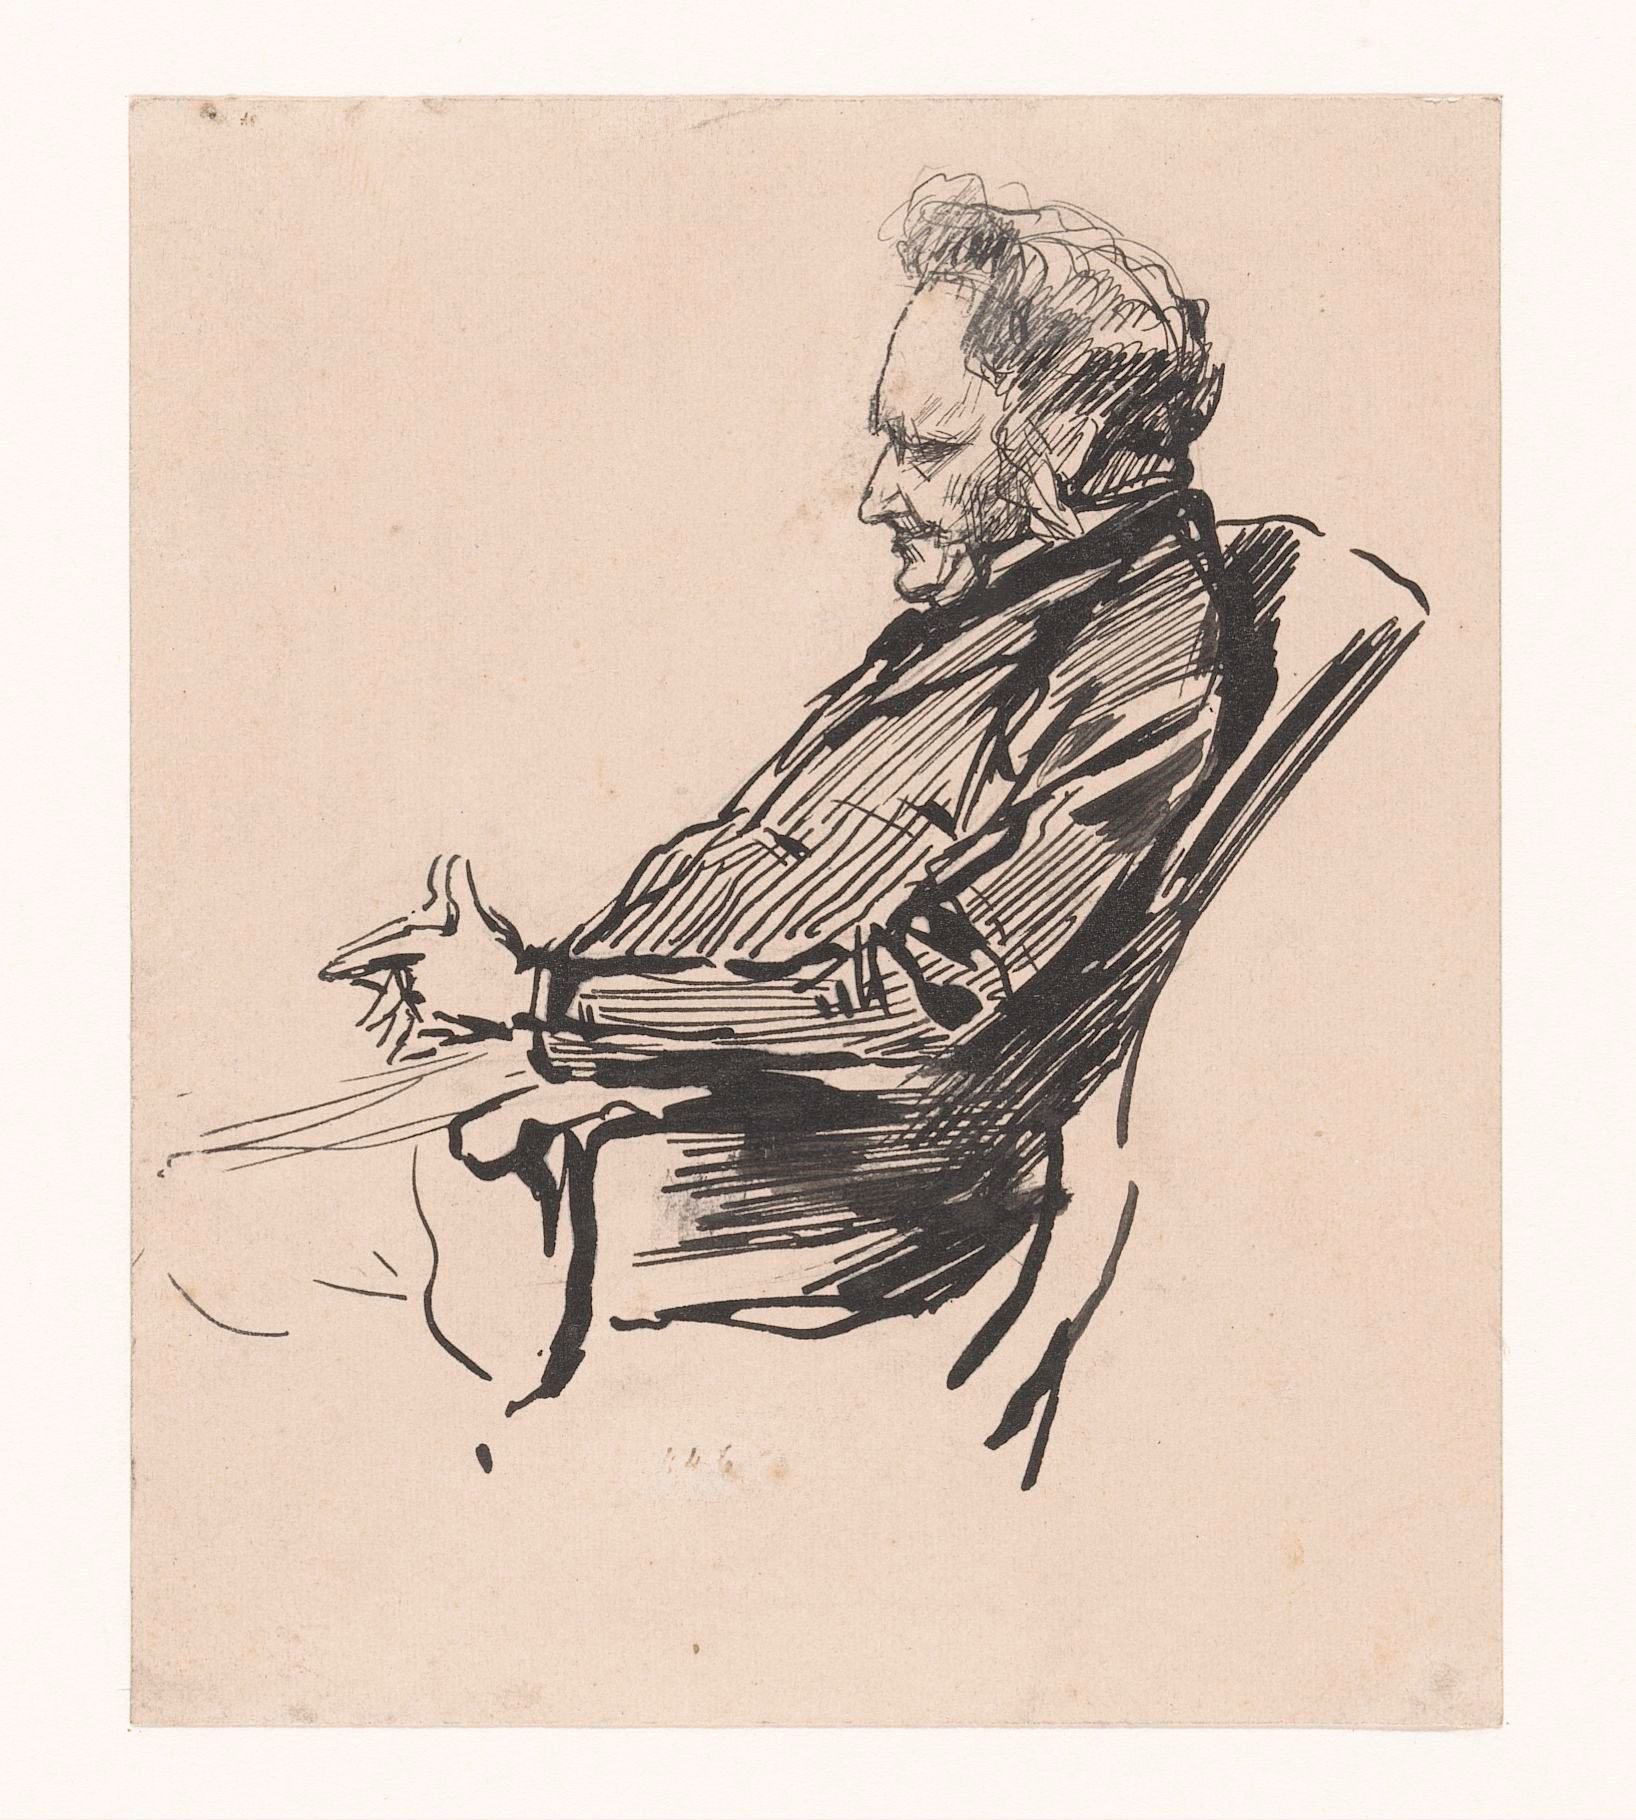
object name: drawing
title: Minister Heemskerck in de Tweede Kamer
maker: pieter de josselin de jong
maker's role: draughtsman, painter, print maker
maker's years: 1861-1906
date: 1887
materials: ink, paper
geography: the hague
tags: amsterdam, the hague, politician, minister ~ government, historical persons, netherlands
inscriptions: date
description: De Minister van Staat en Binnenlandse zaken Mr. J. Heemskerck Azn zittend in stoel, van opzij gezien, halffiguur, de duimen en wijsvingers van zijn handen tegen elkaar gedrukt. Onderdeel van een groep schetsen van de bespreking in de Tweede Kamer van de grondwetsherziening van 1887 gepubliceerd in het weekblad Eigen Haard (1887).